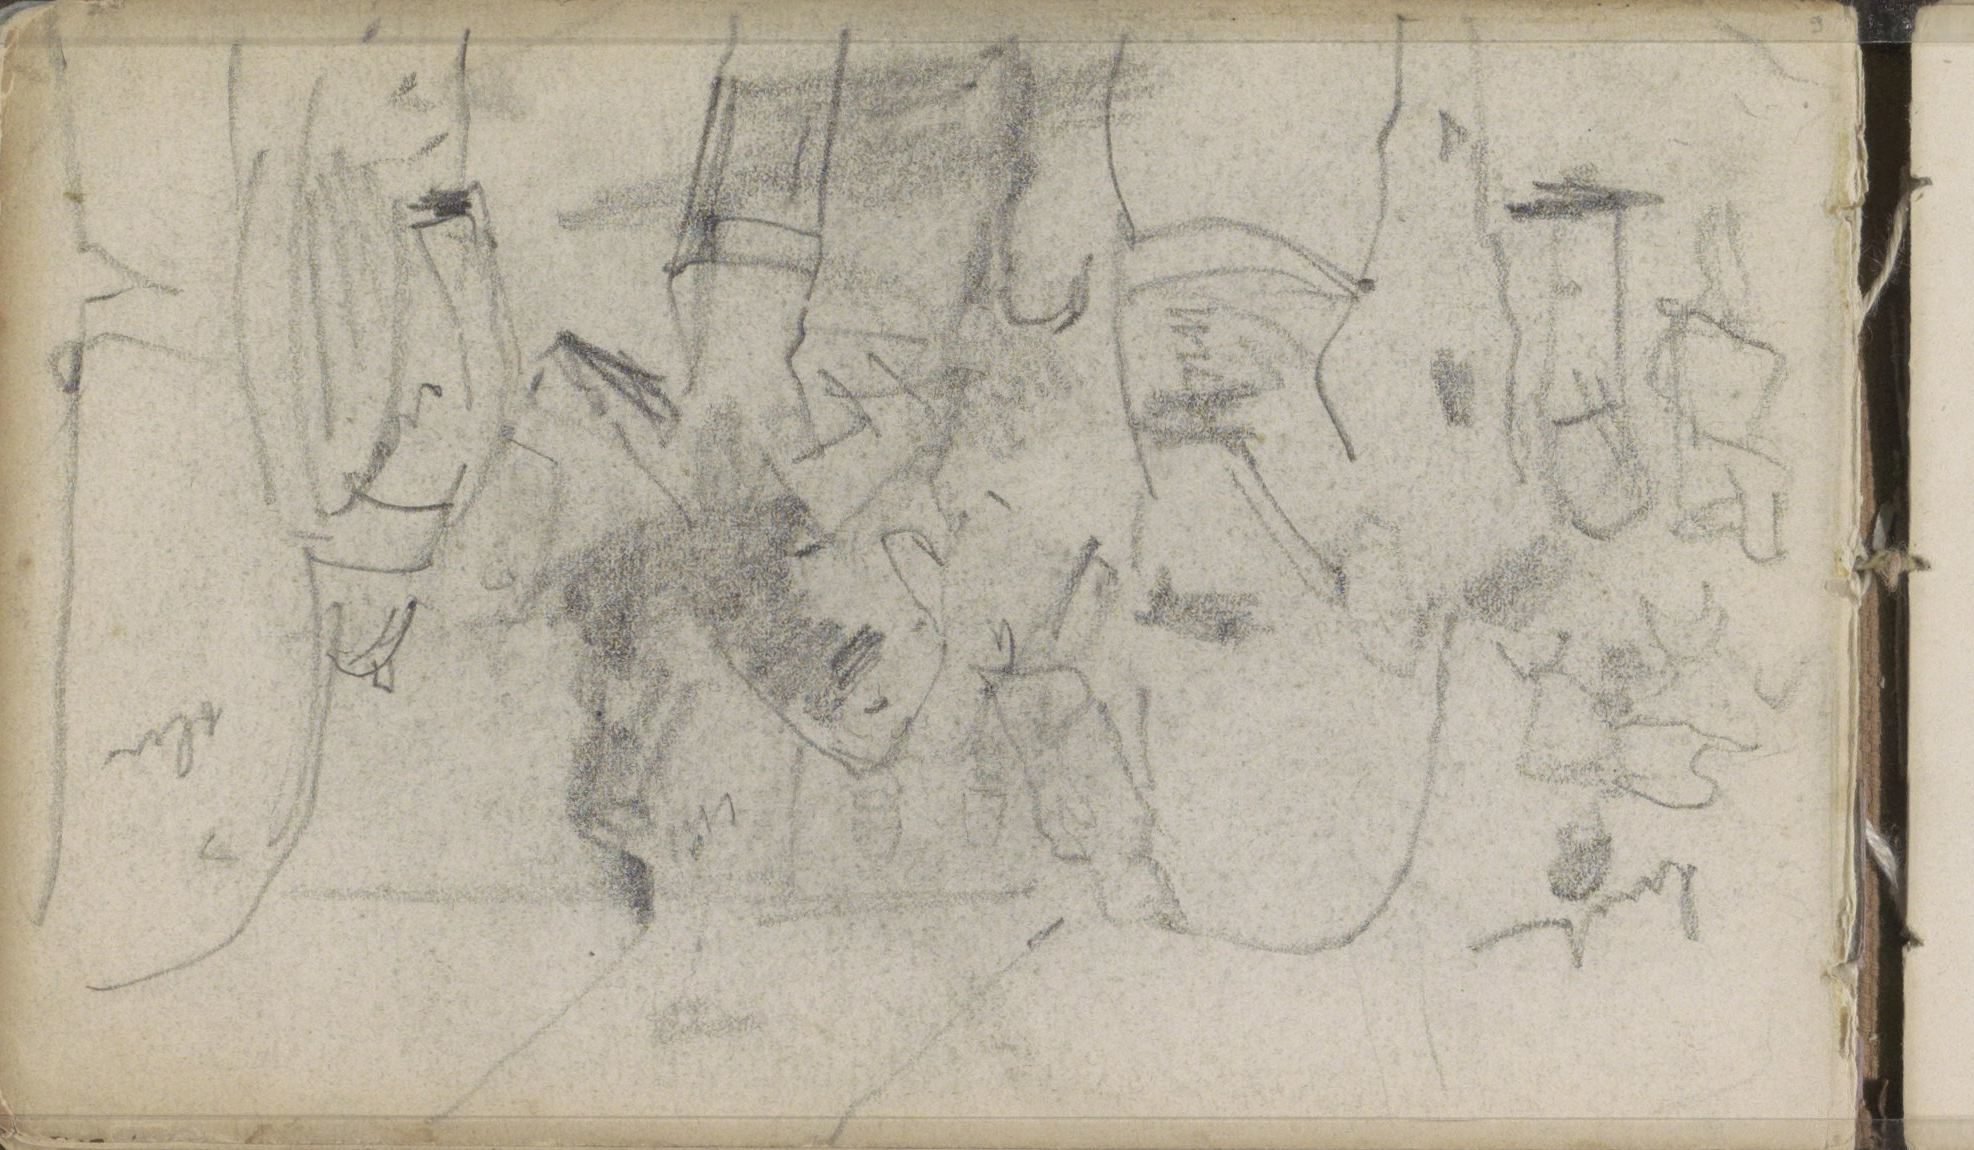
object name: sketchbook leaf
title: Groep figuren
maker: george hendrik breitner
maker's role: draughtsman, painter, print maker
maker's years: 1857-1923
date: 1881-1883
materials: paper, pencil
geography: north brabant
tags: adult man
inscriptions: annotation: ‘lucht’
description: Pagina 9 uit een schetsboek met 42 bladen.